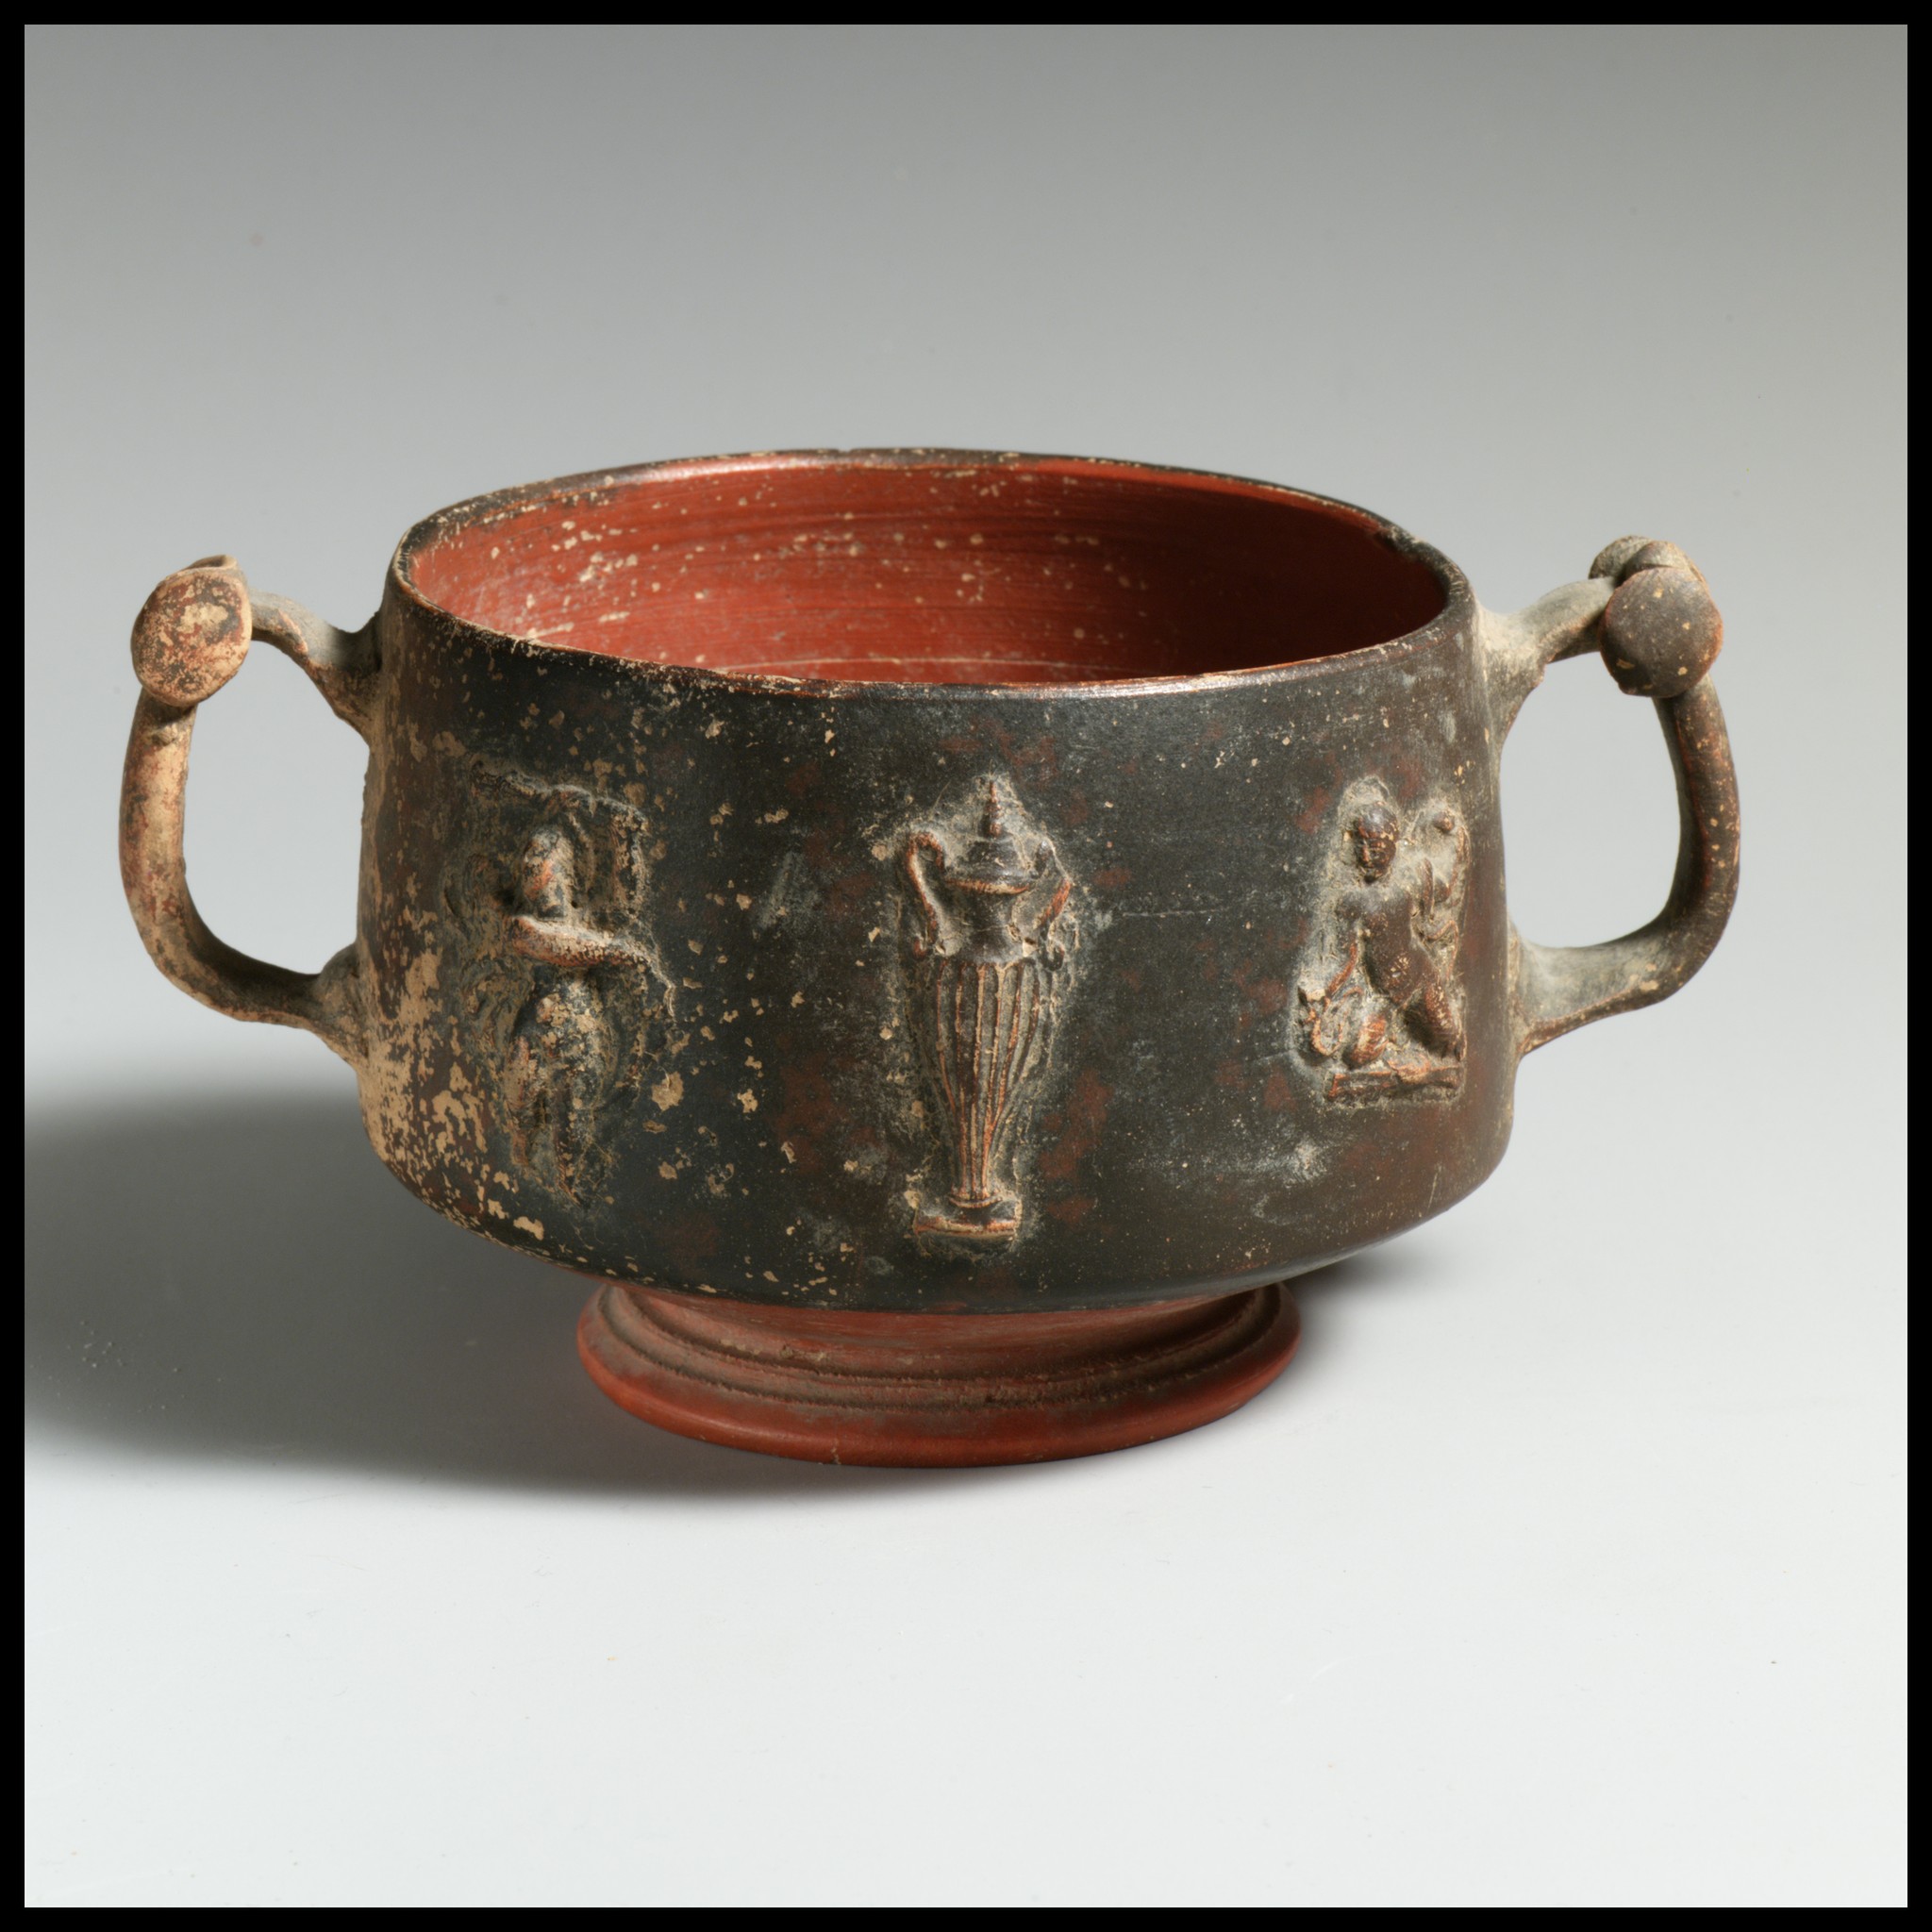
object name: cup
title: Terracotta cup with appliqués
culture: greek, pergamene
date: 150-100 BCE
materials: terracotta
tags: eros,snakes